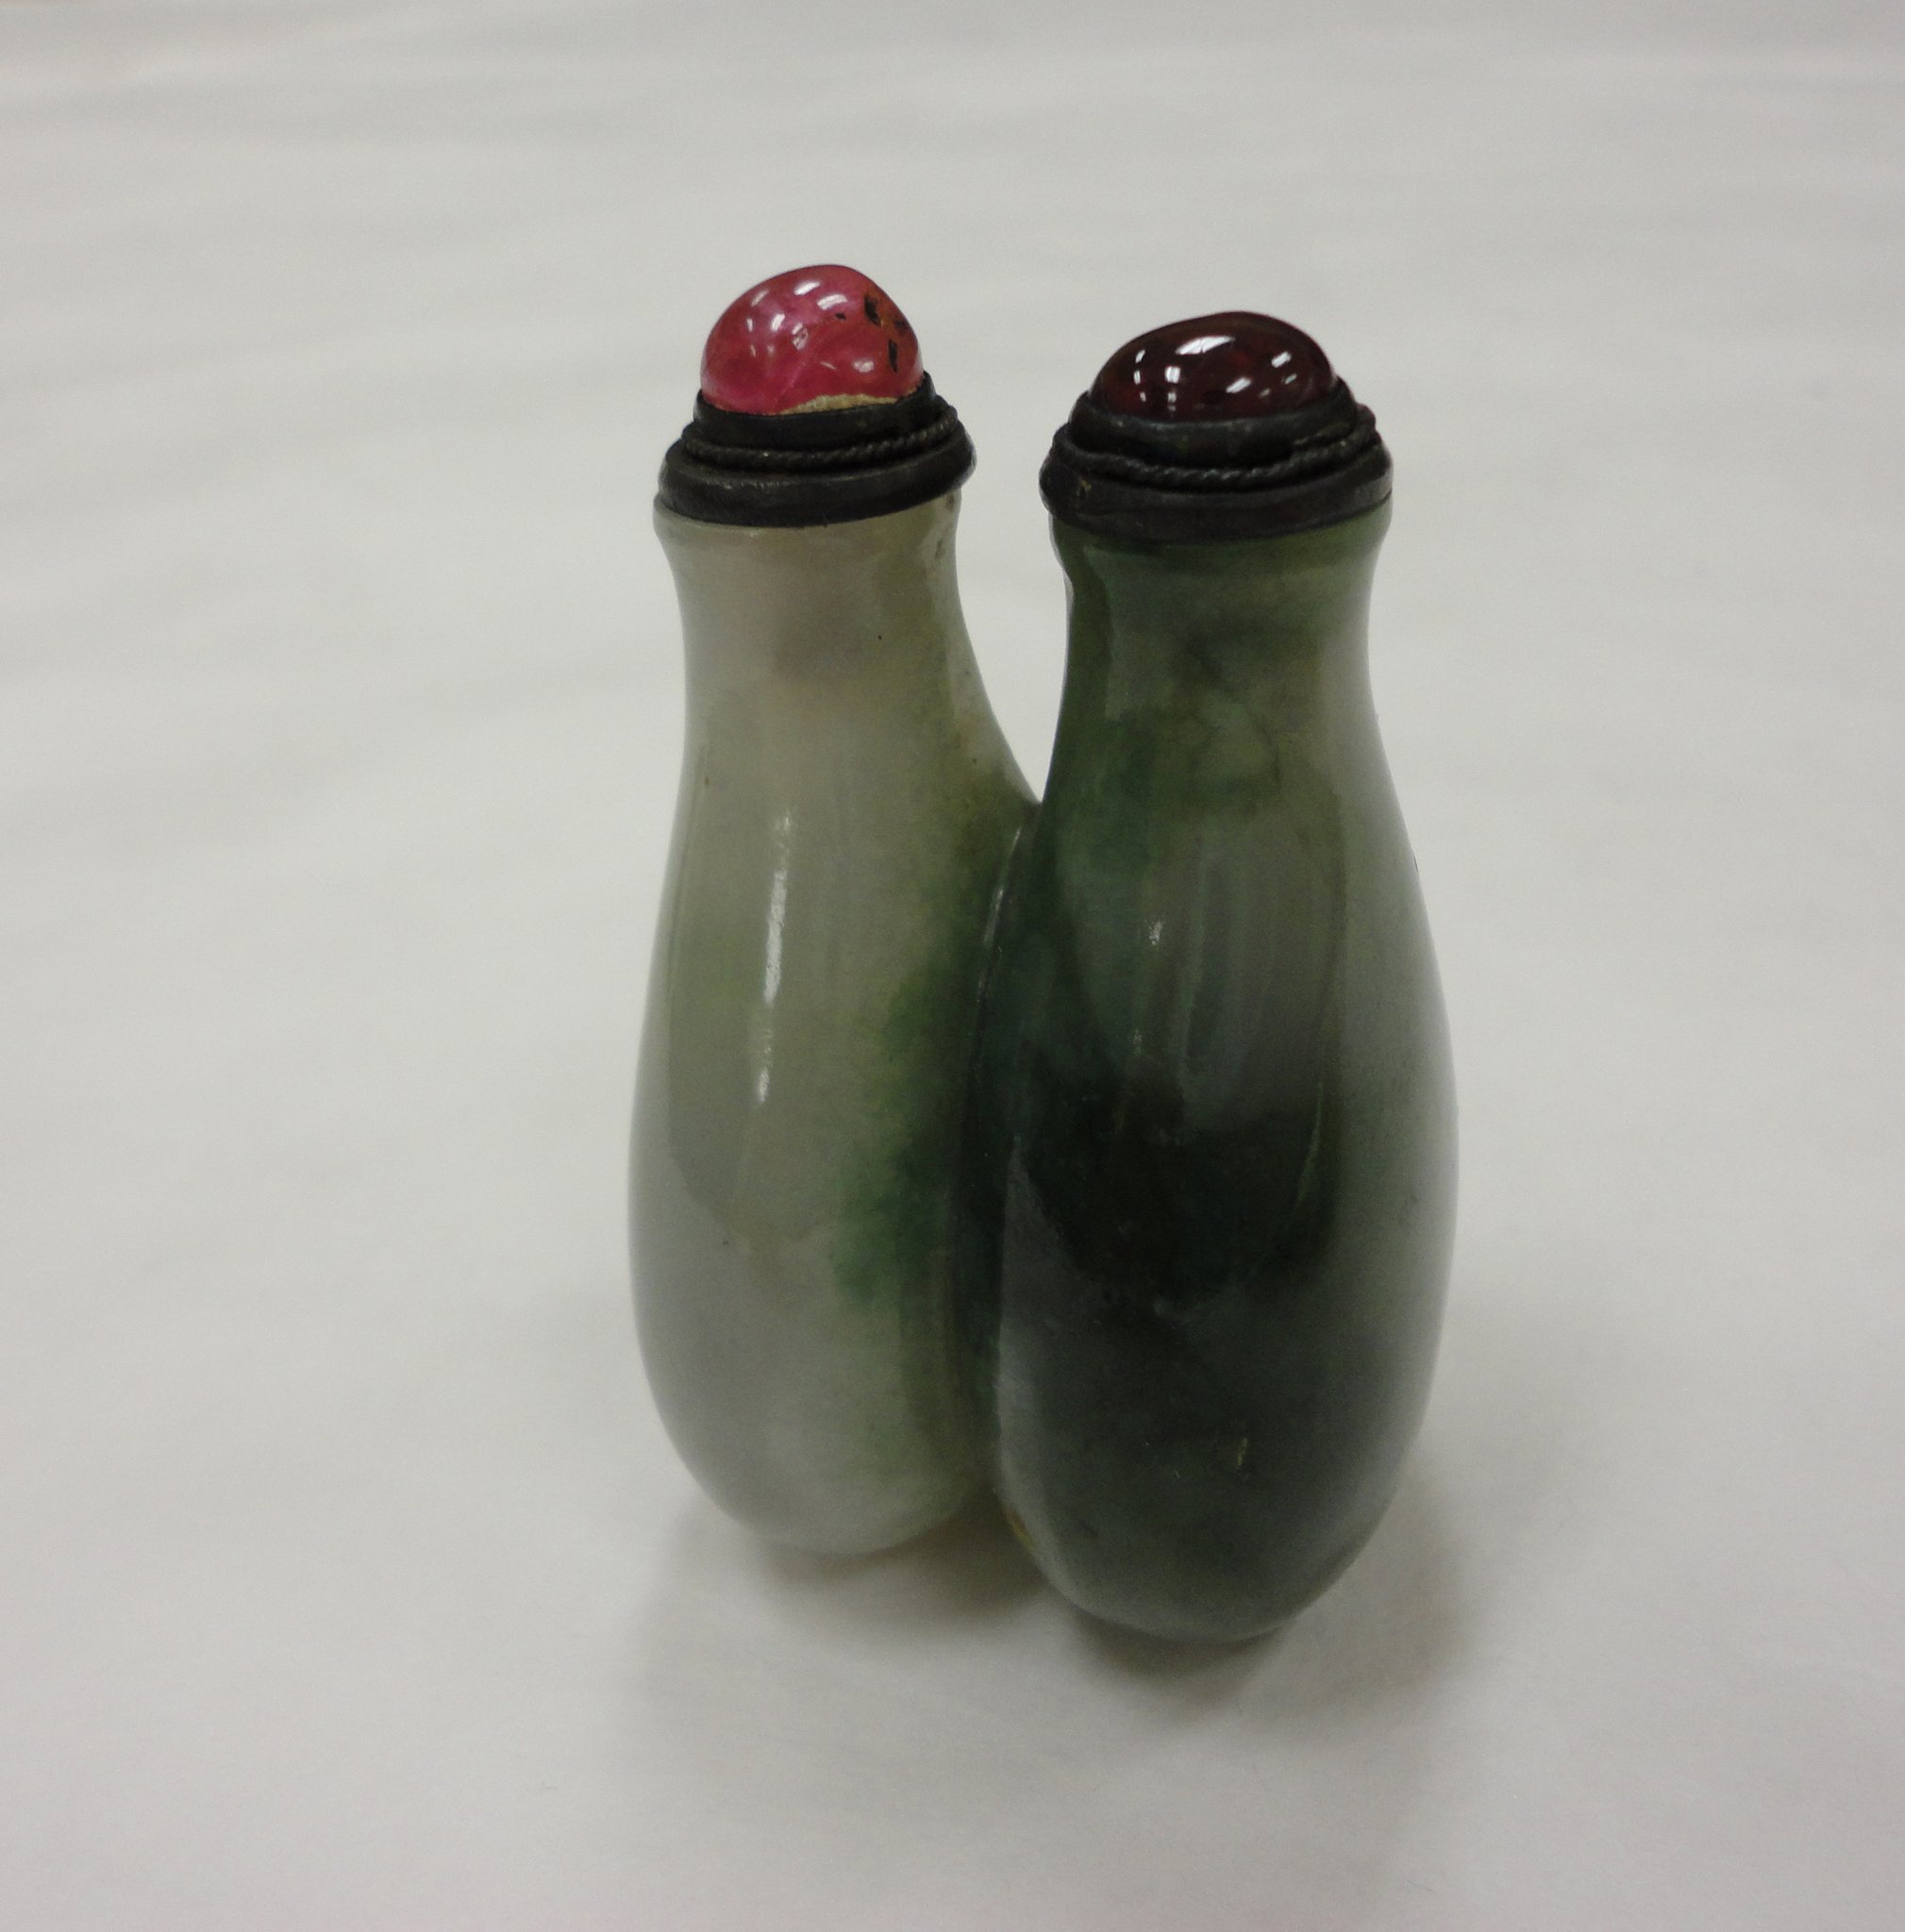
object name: snuff bottle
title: Twin Snuff Bottles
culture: chinese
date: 1736-1795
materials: gemstone, jade, quartz